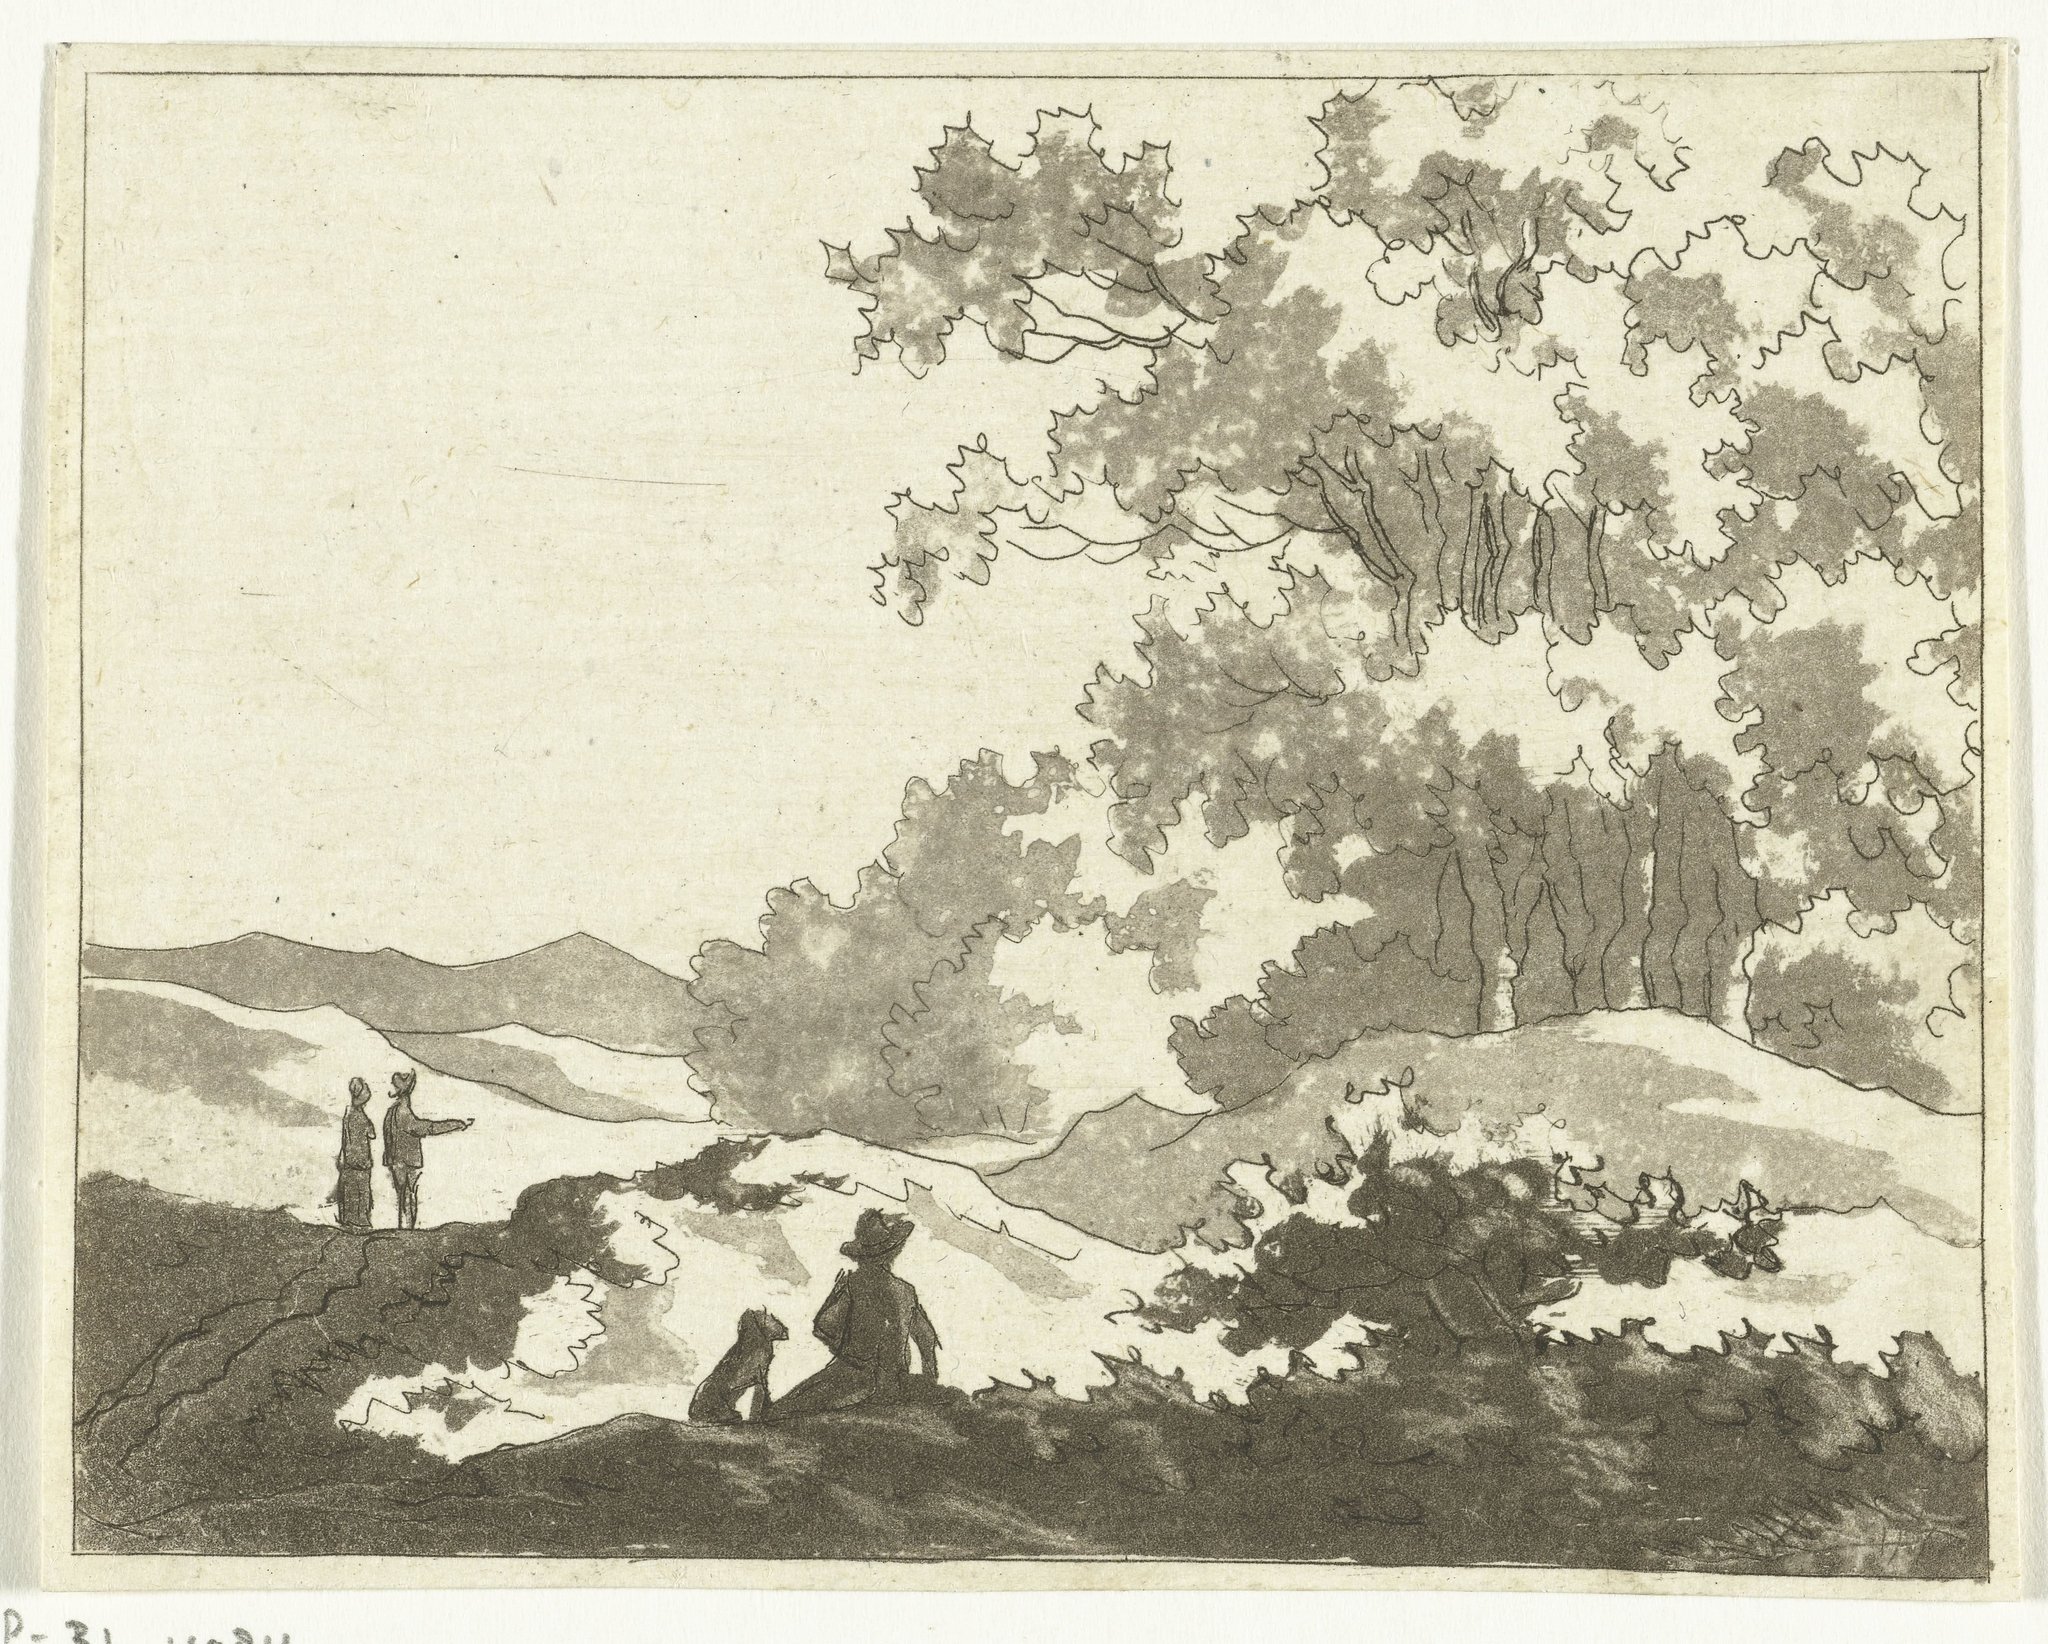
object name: print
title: Duinlandschap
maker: anthonie van den bos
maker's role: draughtsman, print maker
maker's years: 1763-1838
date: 1778-1838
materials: paper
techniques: aquatint, etching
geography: netherlands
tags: dunes (sea not visible); in the dunes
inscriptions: collector's mark: Lugt 2228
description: Twee wandelaars lopen op een pad door de duinen. Een derde wandelaar rust uit. Hij zit met zijn hond op de grond en kijkt naar een groep bomen.